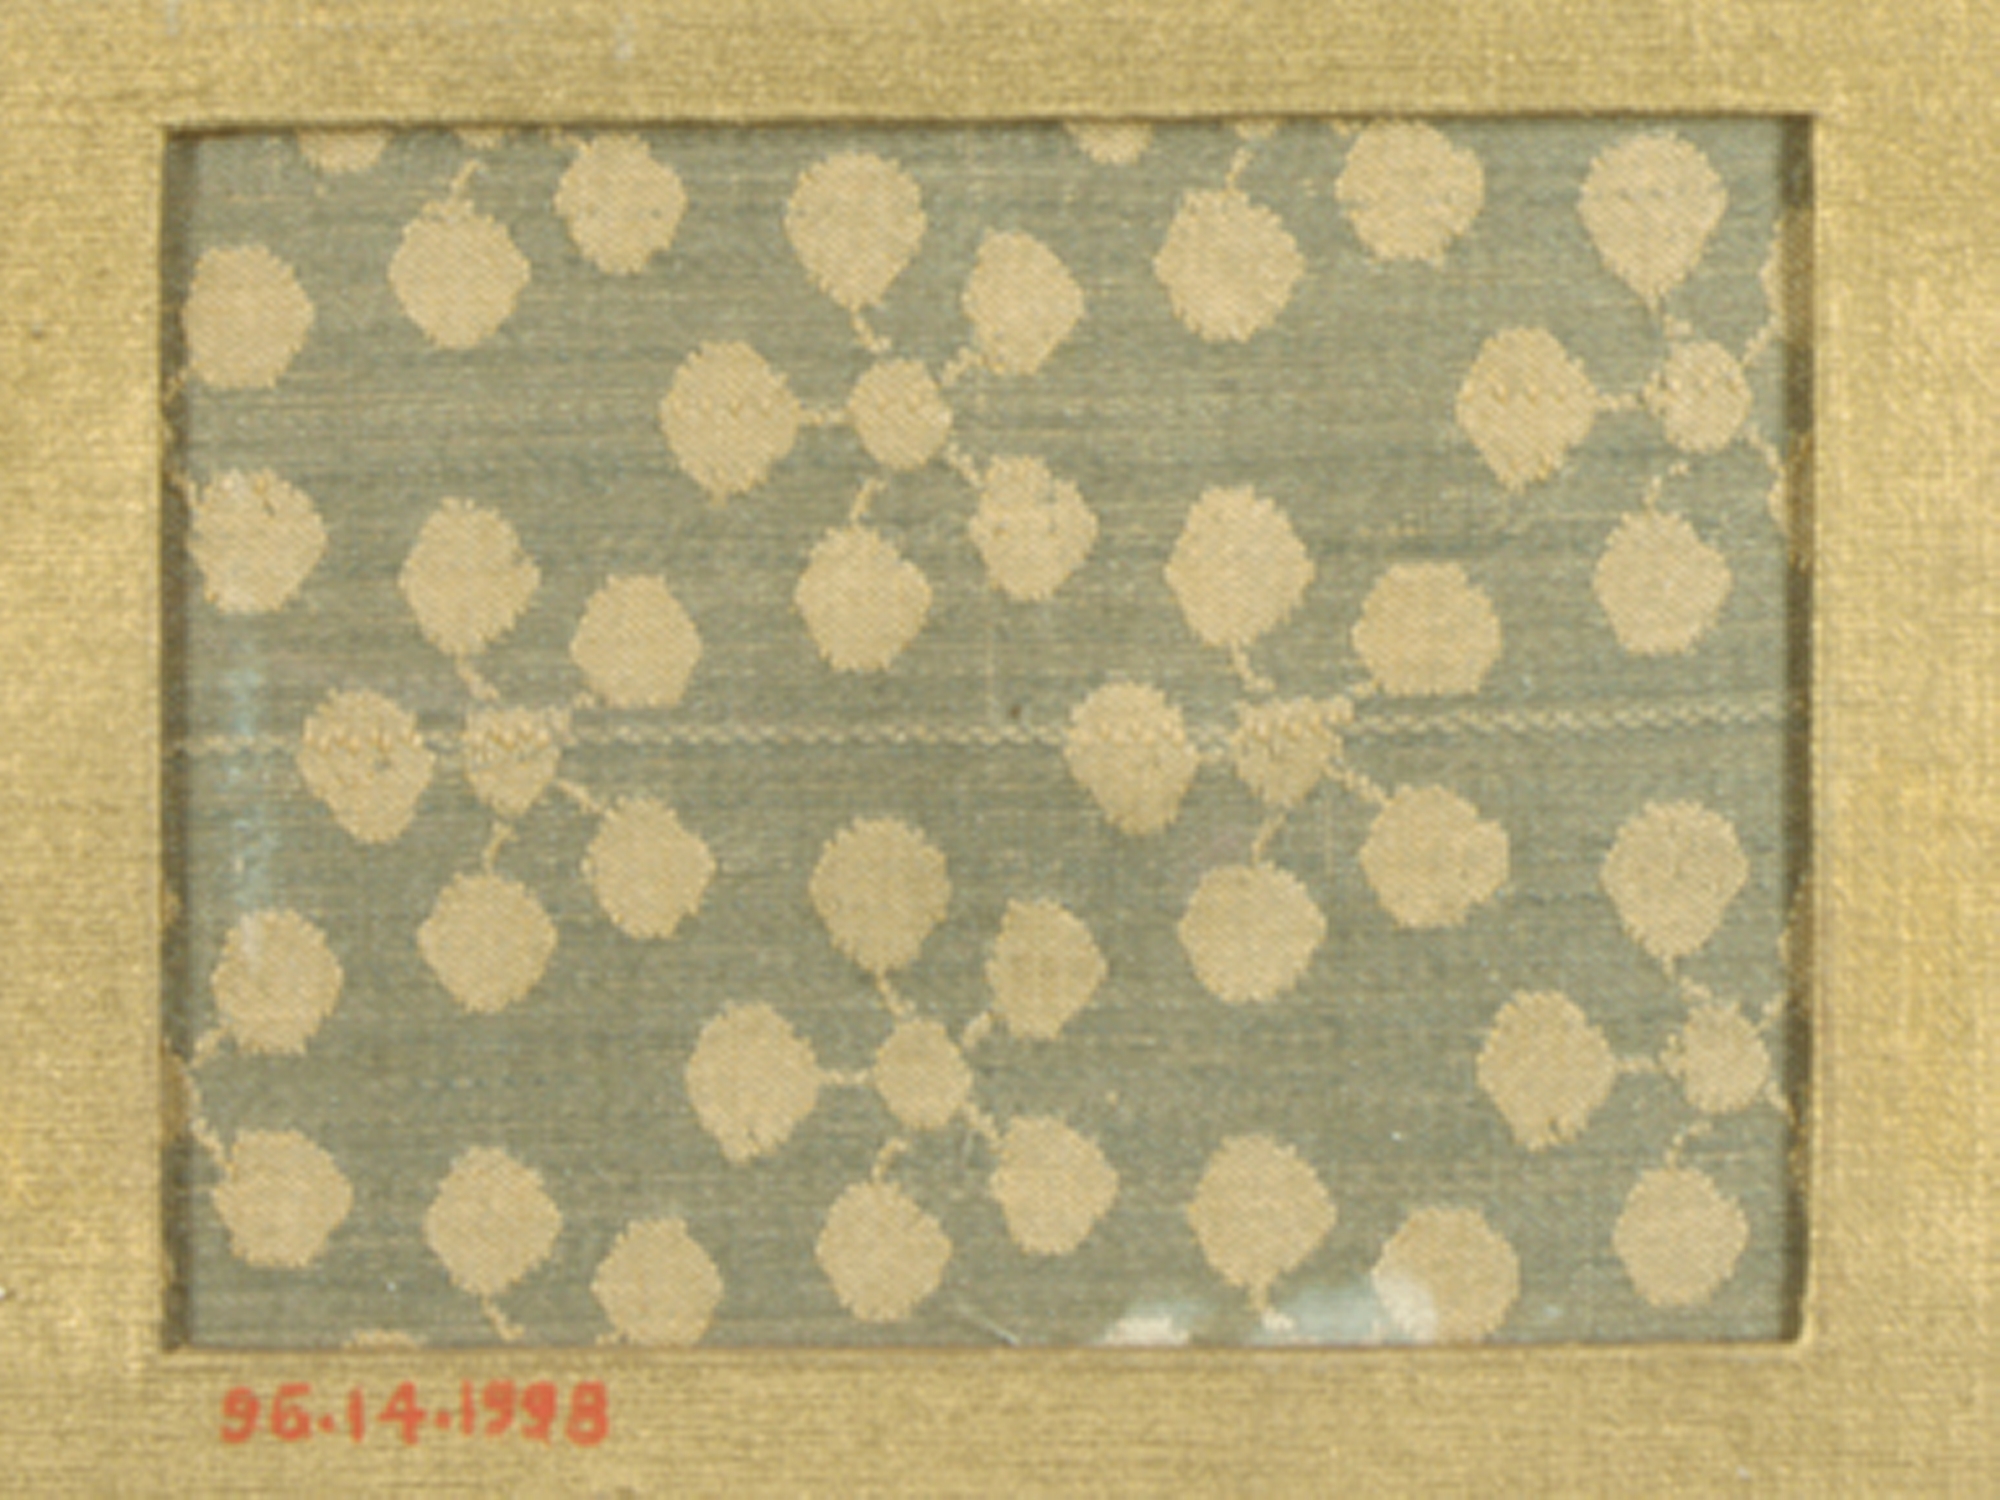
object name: piece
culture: japanese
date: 1701-1900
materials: silk